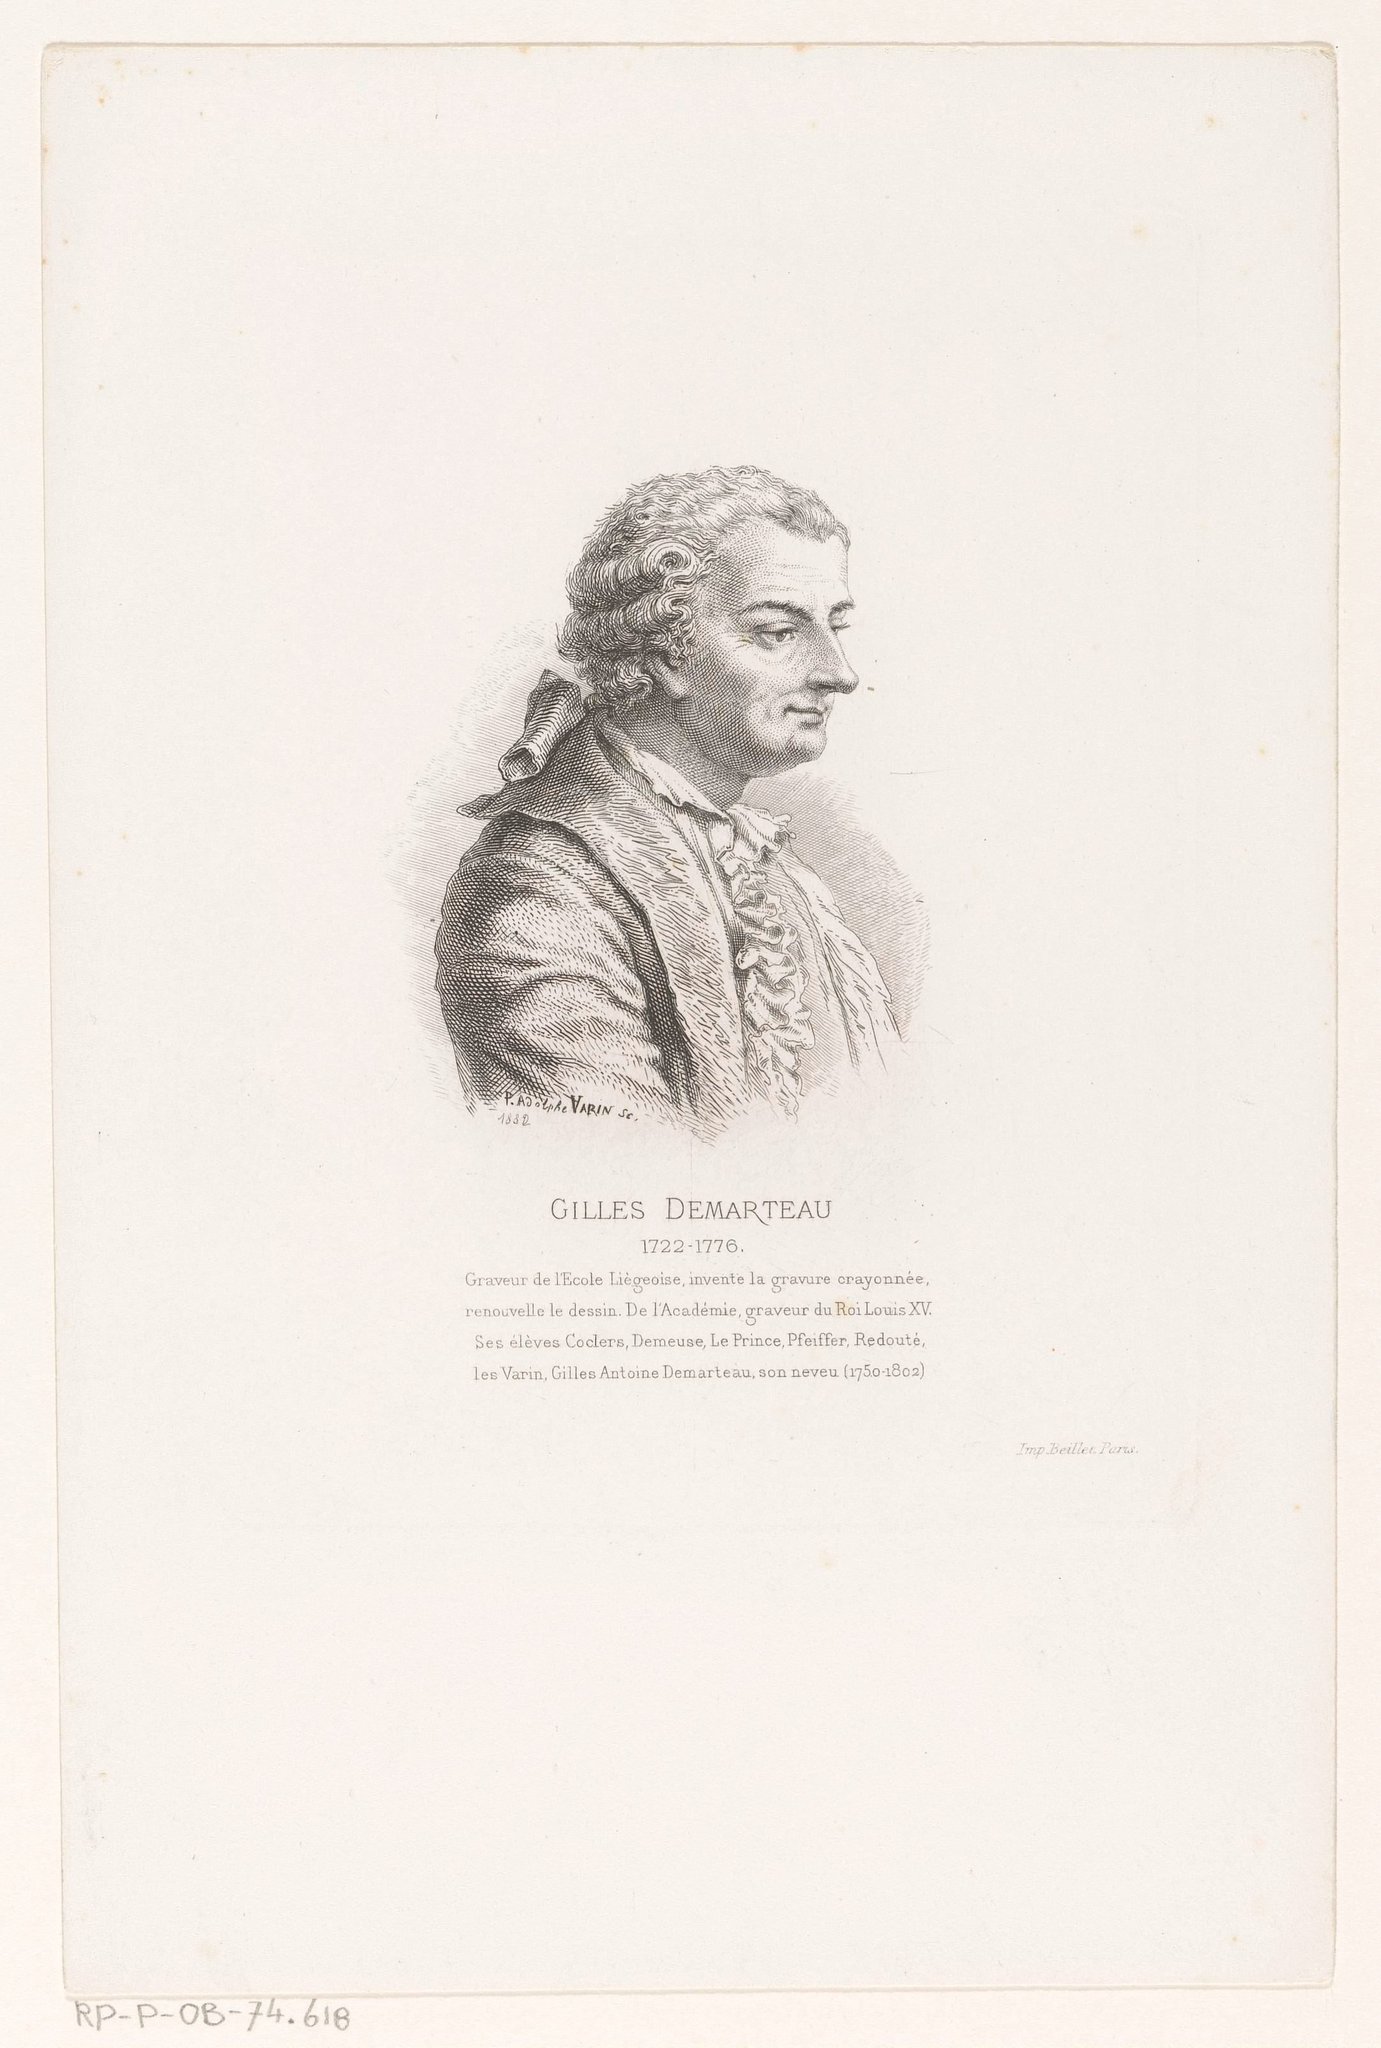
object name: print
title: Portret van Gilles Demarteau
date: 1882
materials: paper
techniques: engraving, etching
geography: paris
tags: liège, paris, print maker, gilles demarteau, historical persons, portrait, self-portrait of artist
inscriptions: collector's mark: Lugt 2228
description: Prent uit: École liégeoise. Les Graveurs. Leurs portraits, reproduits au burin, d'après les originaux, par Adolphe Varin, 1366-1850. Avec notes historiques (...). Parijs: Fr. Gobbaerts, ca. 1684.